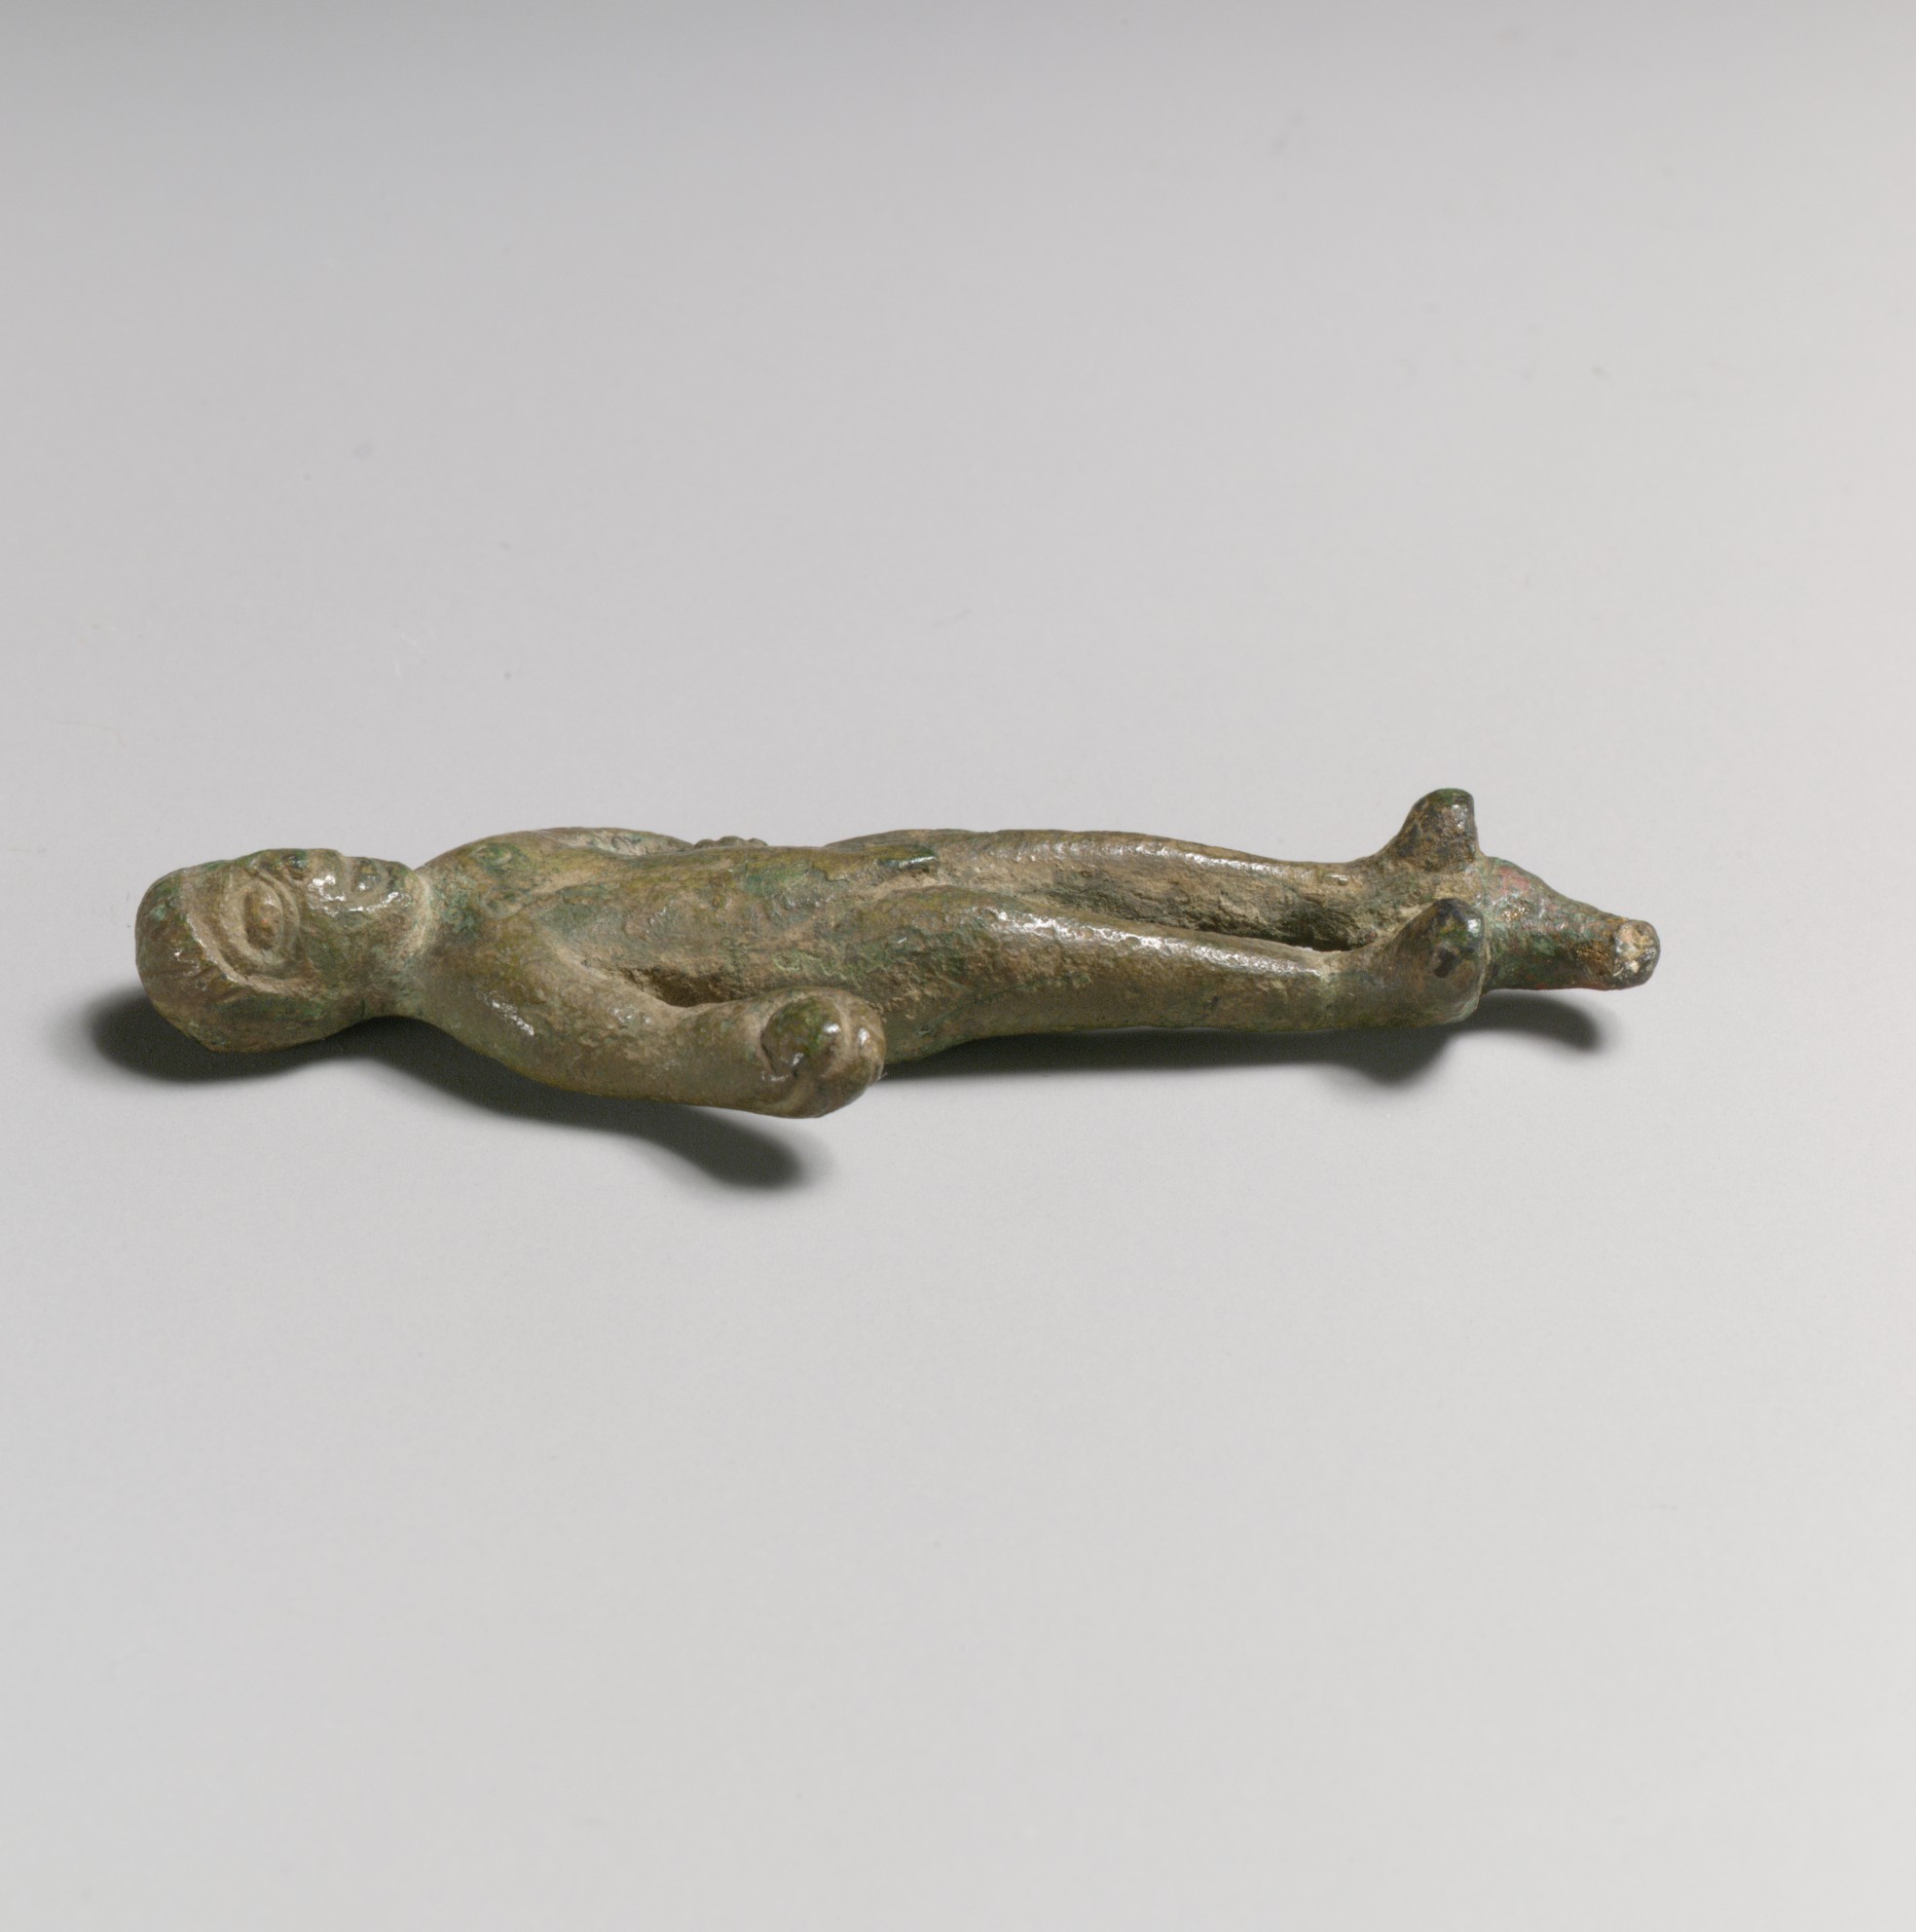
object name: statuette of a man with object in hand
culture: italic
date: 400-1 BCE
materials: bronze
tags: men